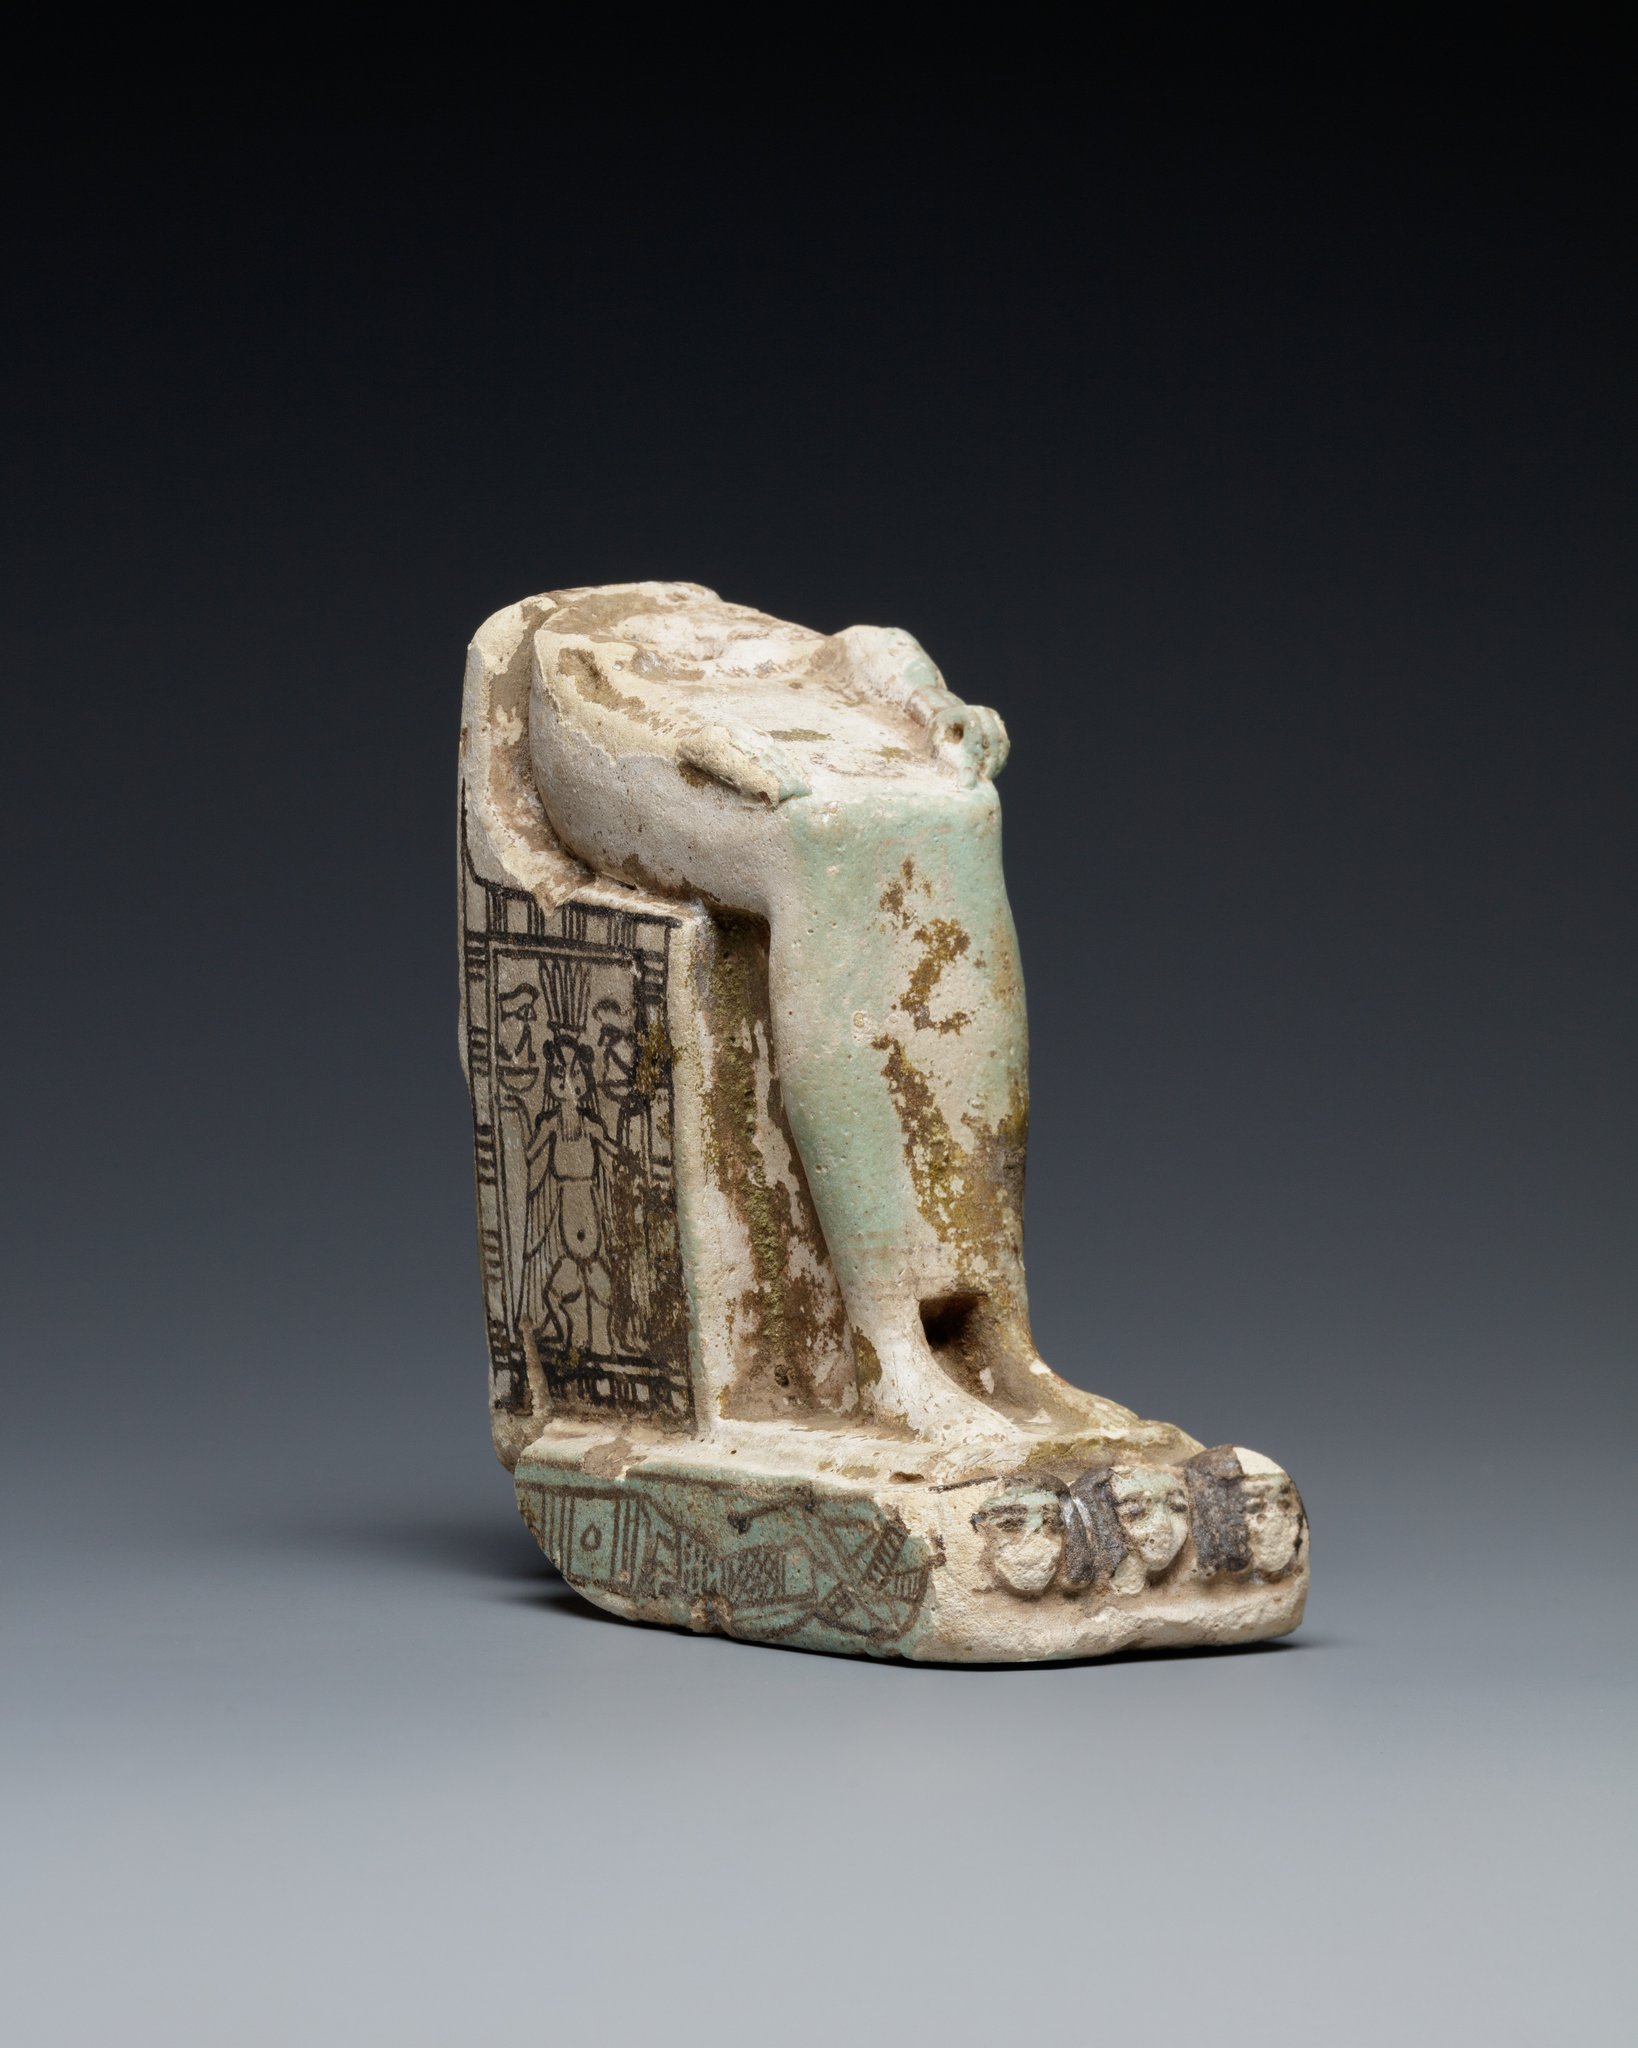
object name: statue, goddess, throne, lower body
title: Lower half of a goddess on a throne with Bes figures, its base formed by prostrate captives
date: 1295-1070 BCE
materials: faience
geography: egypt